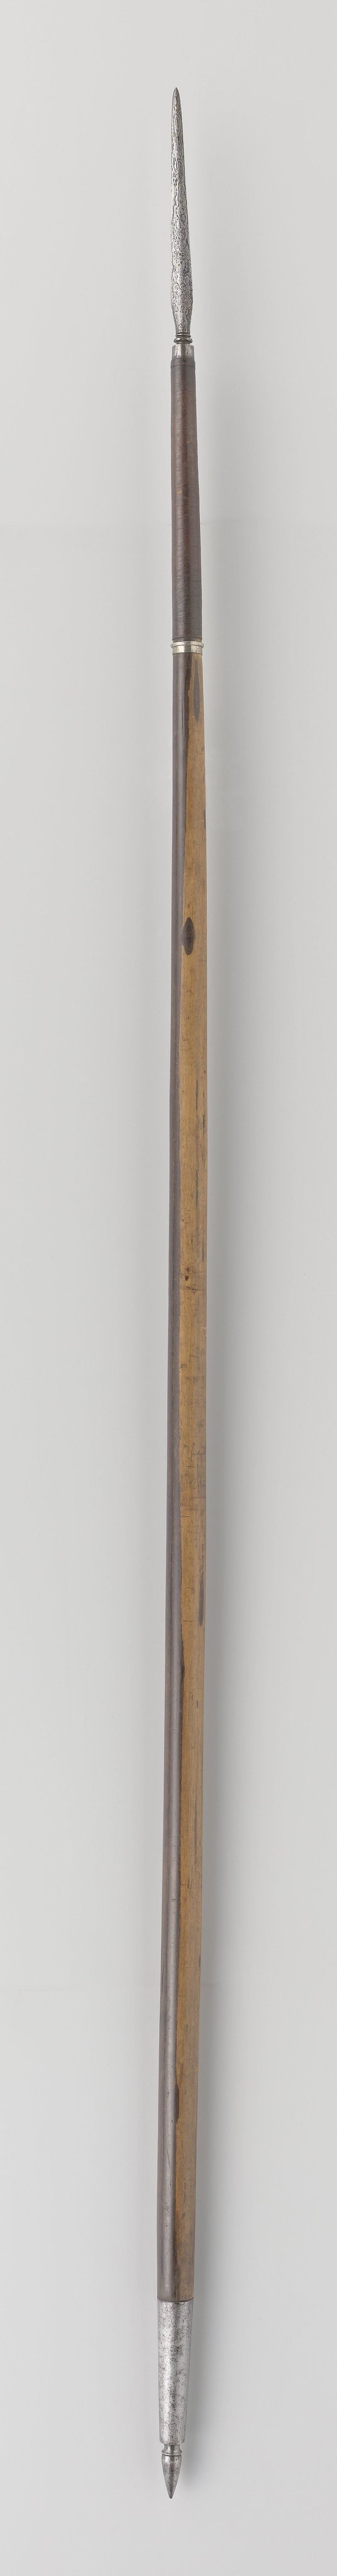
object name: pike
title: Lans uit het wapenrek van Gouverneur-Generaal J.C. baron Baud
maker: Anonymous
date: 1800-1900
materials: iron, fiber, wood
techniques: casting, cutting, forging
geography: kalimantan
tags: the hague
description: Ronde houten schacht met aan onderzijde ijzeren omhulsel uitlopend in een kegelvormige punt. Bovenzijde van schacht is omwikkeld met touw waaromheen een ijzeren ring. Korte smalle kling, uitlopend in een spitse punt. Versiering (gewaterd staal) op kling.